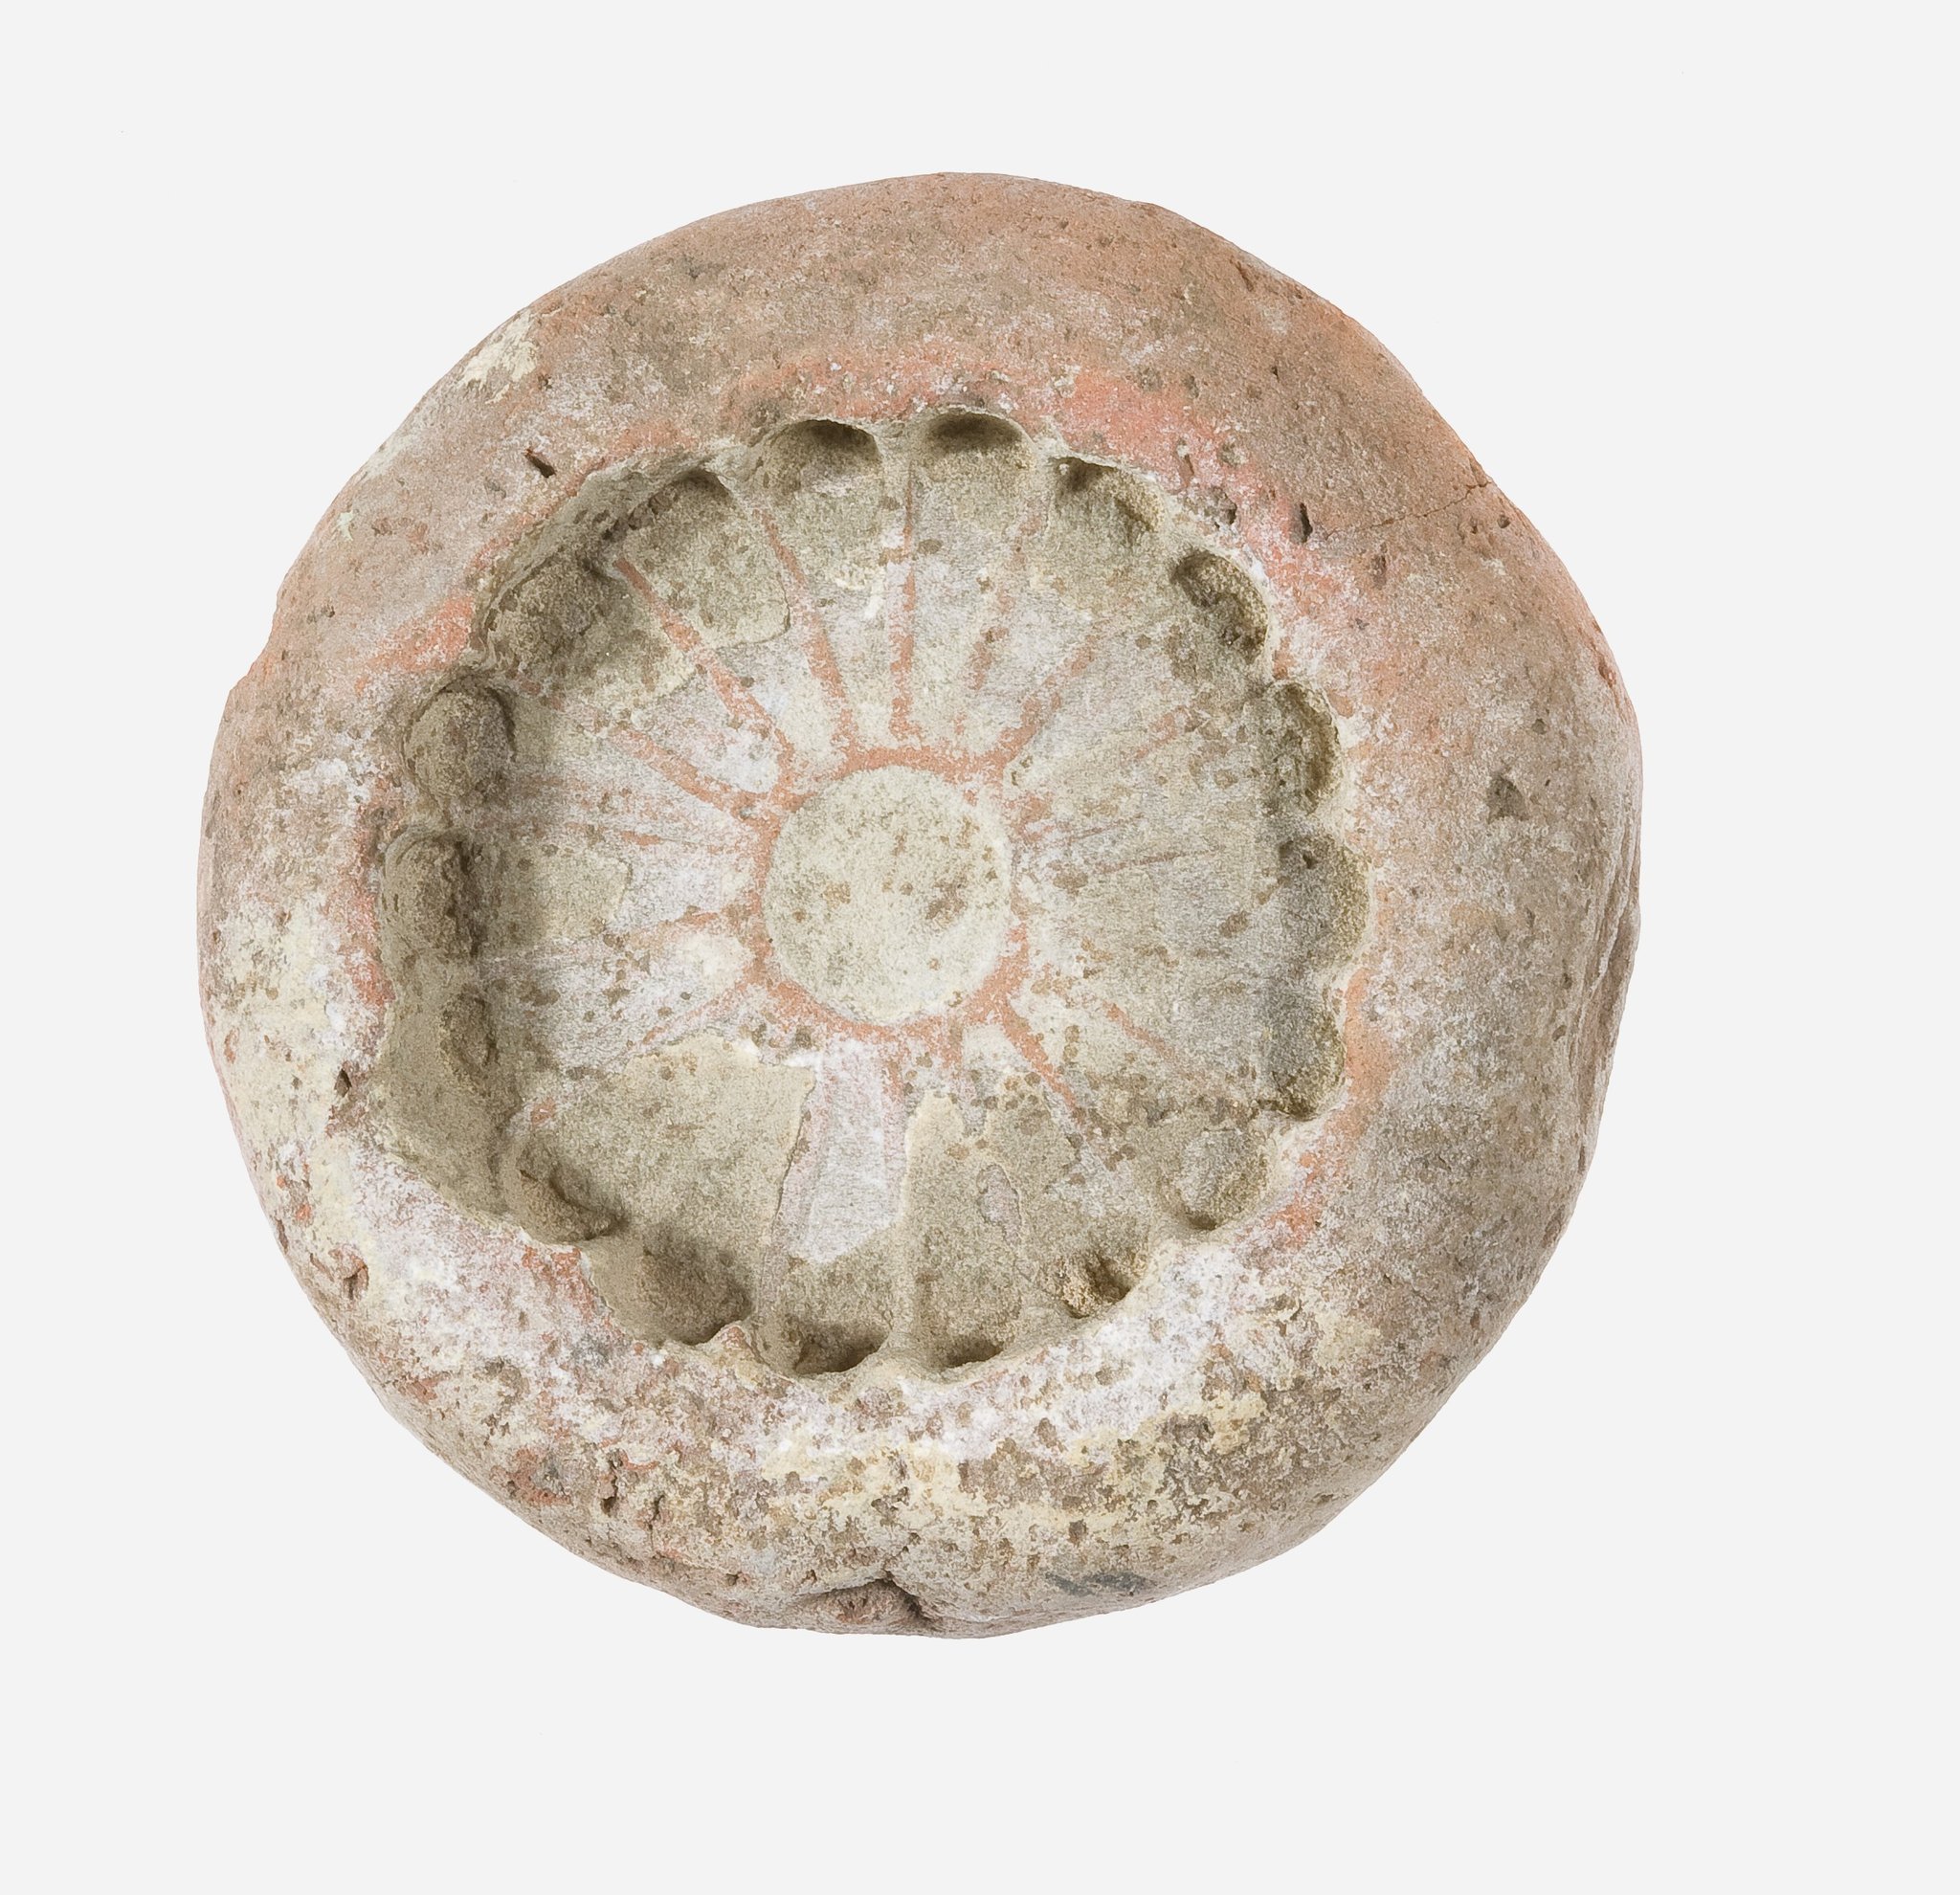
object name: mold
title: Big Daisy Mold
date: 1390-1352 BCE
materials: pottery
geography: egypt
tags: daisies